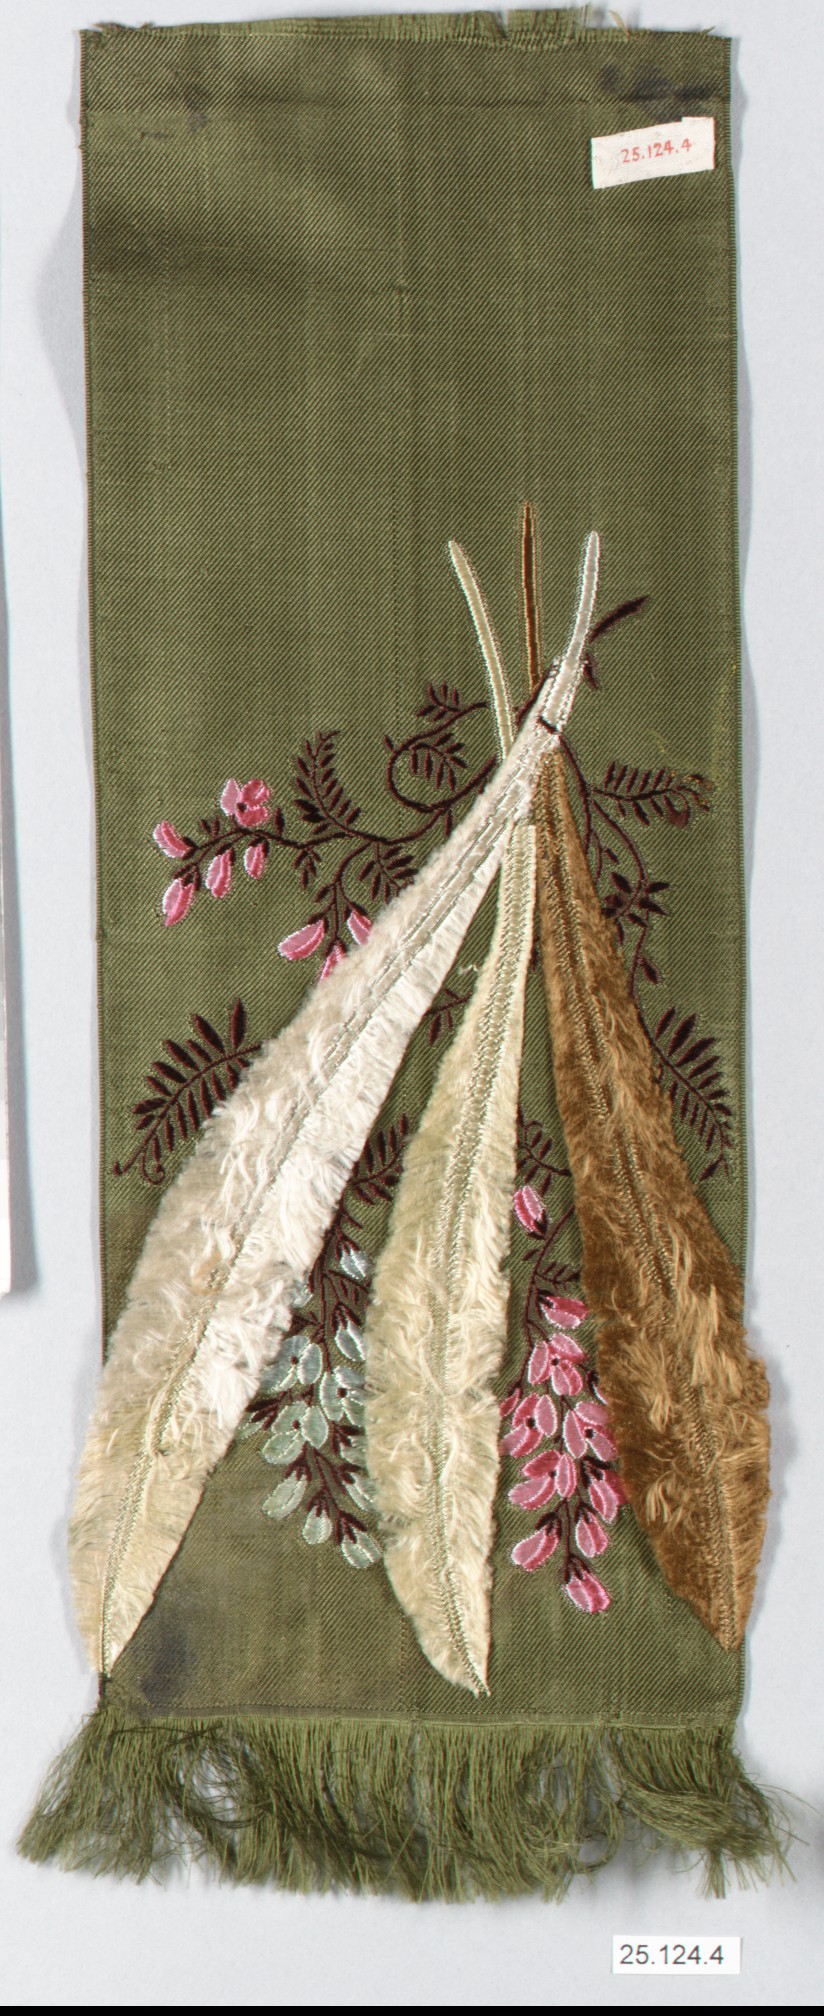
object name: necktie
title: Woman's necktie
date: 1870-1880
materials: silk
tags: feathers,flowers